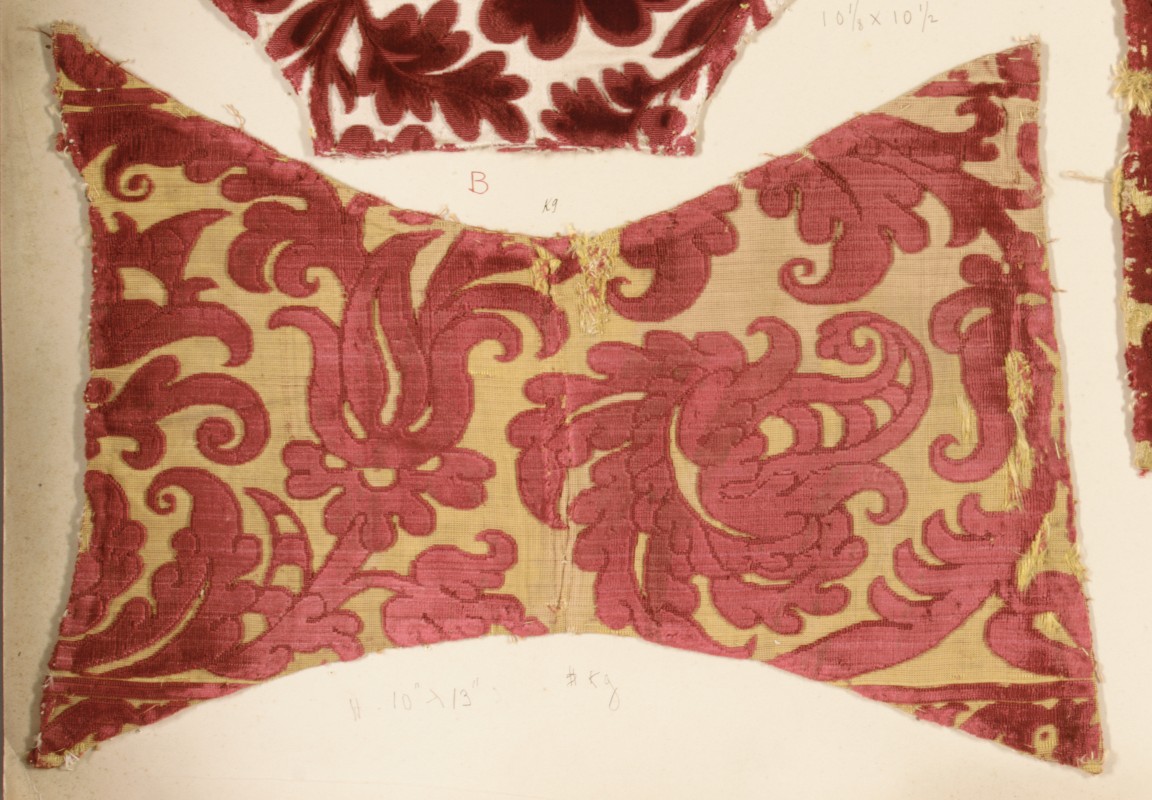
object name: fragment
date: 1601-1700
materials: silk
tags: leaves